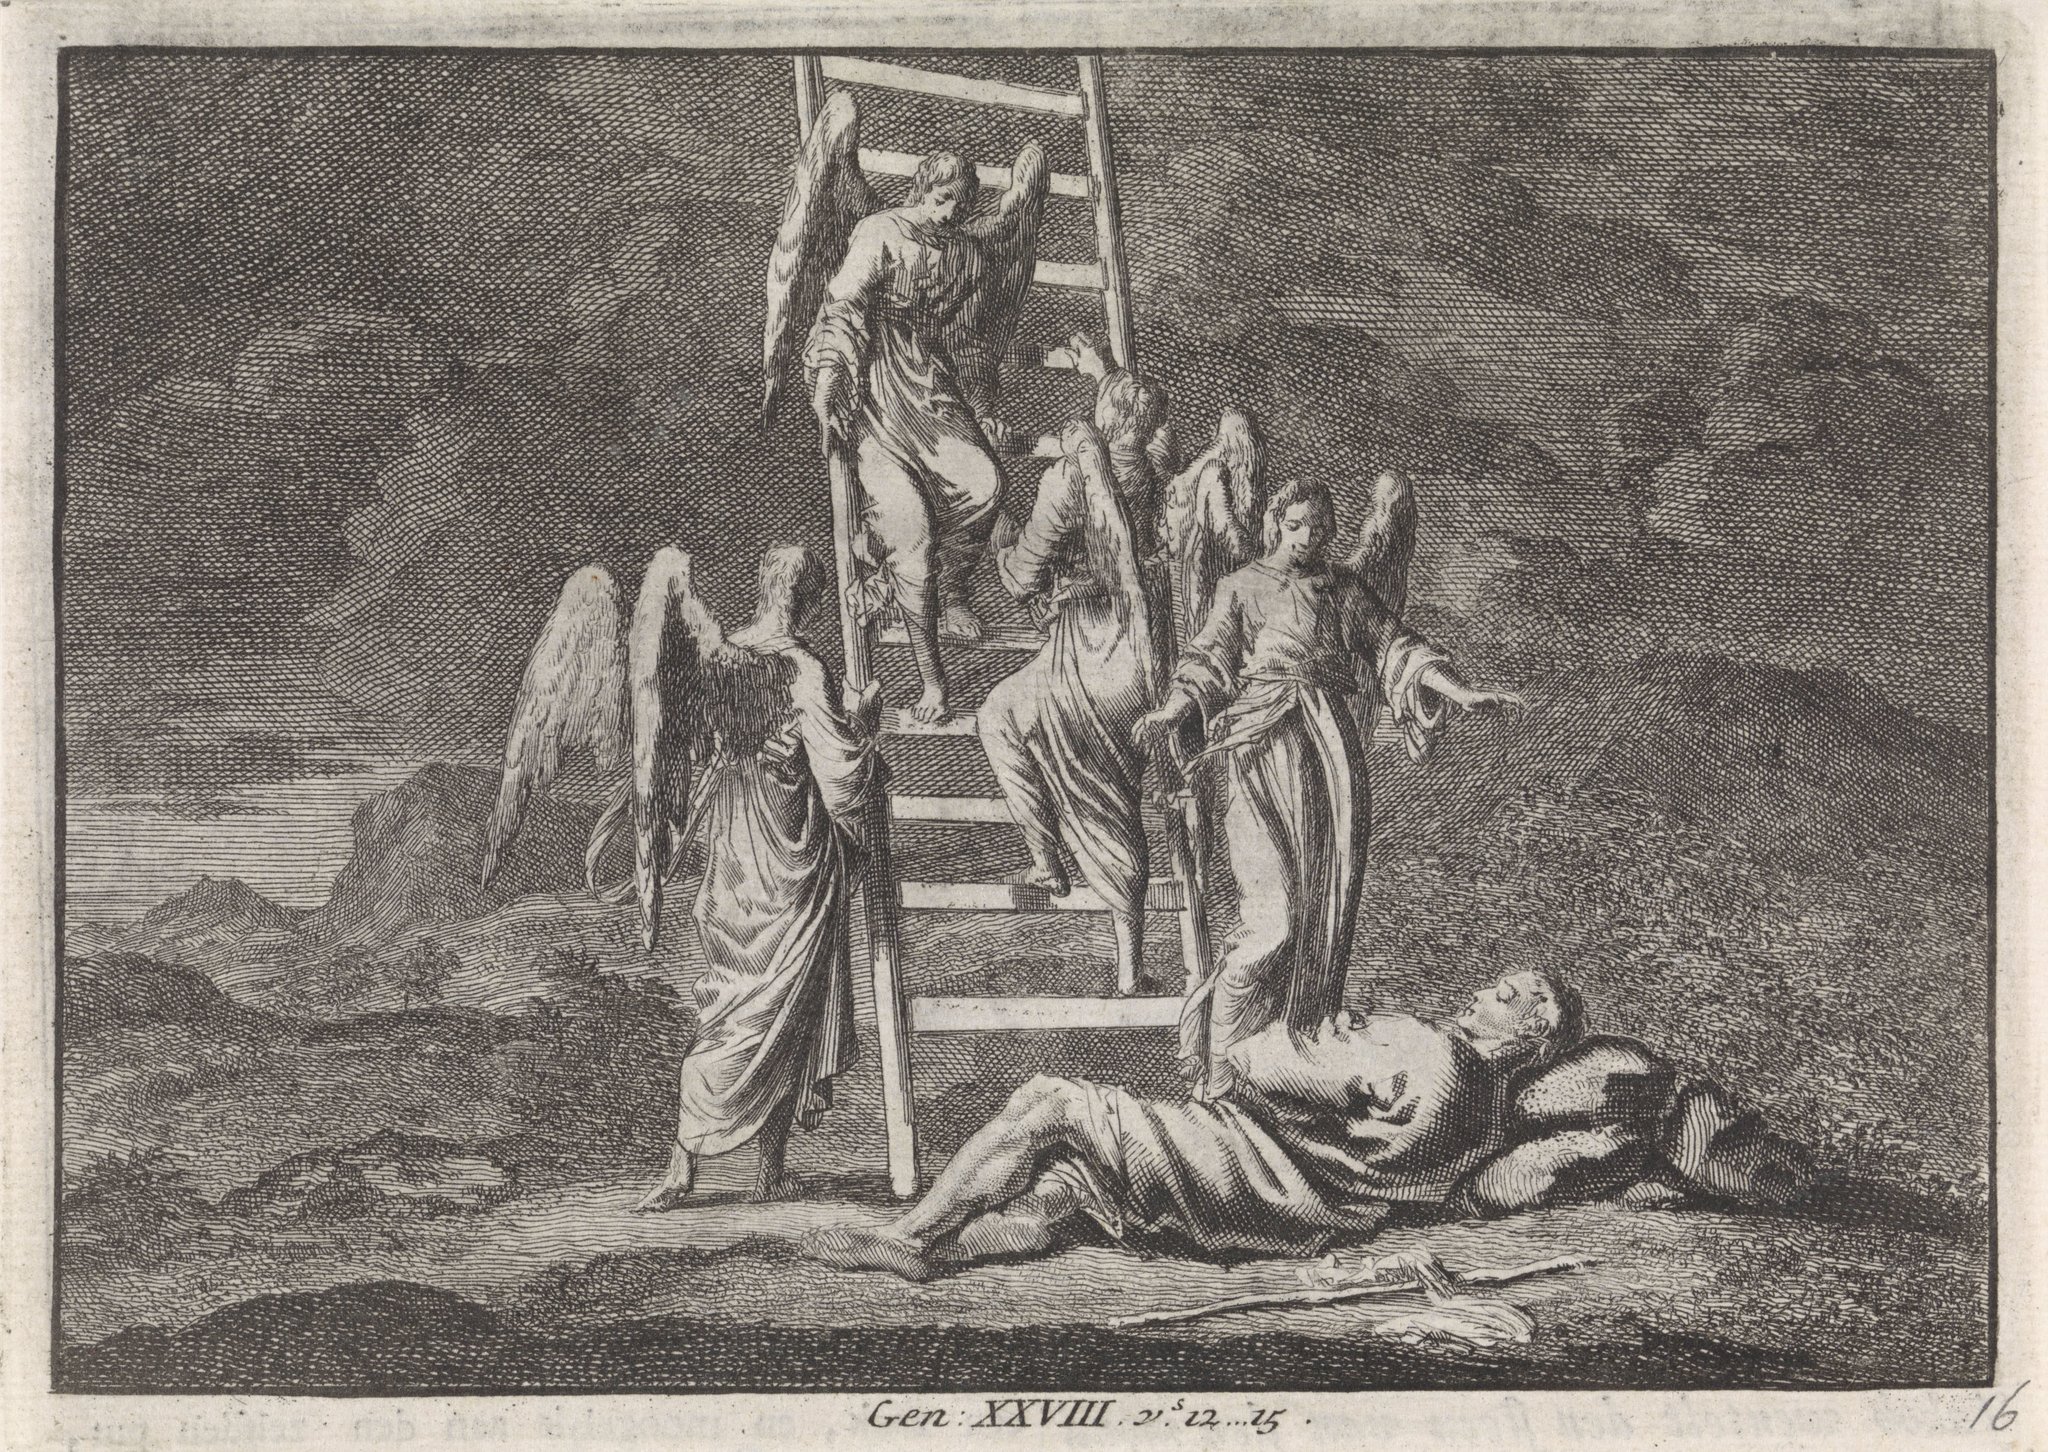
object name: book illustration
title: Jakobs ladder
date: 1703-1762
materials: paper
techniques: etching, letterpress printing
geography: amsterdam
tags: the dream of jacob: while sleeping on the ground with a stone for pillow jacob sees a ladder reaching from earth to heaven with angels going up and down; usually with god at the top of the ladder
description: De prent komt een eerste keer voor als boekillustratie voor David Martin. Historie des Ouden en Nieuwen Testaments. Amsterdam, Pieter Mortier, 1703. Deel I. De boekillustraties voor de Mortierbijbel hebben verschillende staten en kopieën, waarbij de chronologische volgorde moeilijk te achterhalen valt. Als boekillustraties werden ze bovendien herhaaldelijk opnieuw gebruikt voor andere boekwerken.